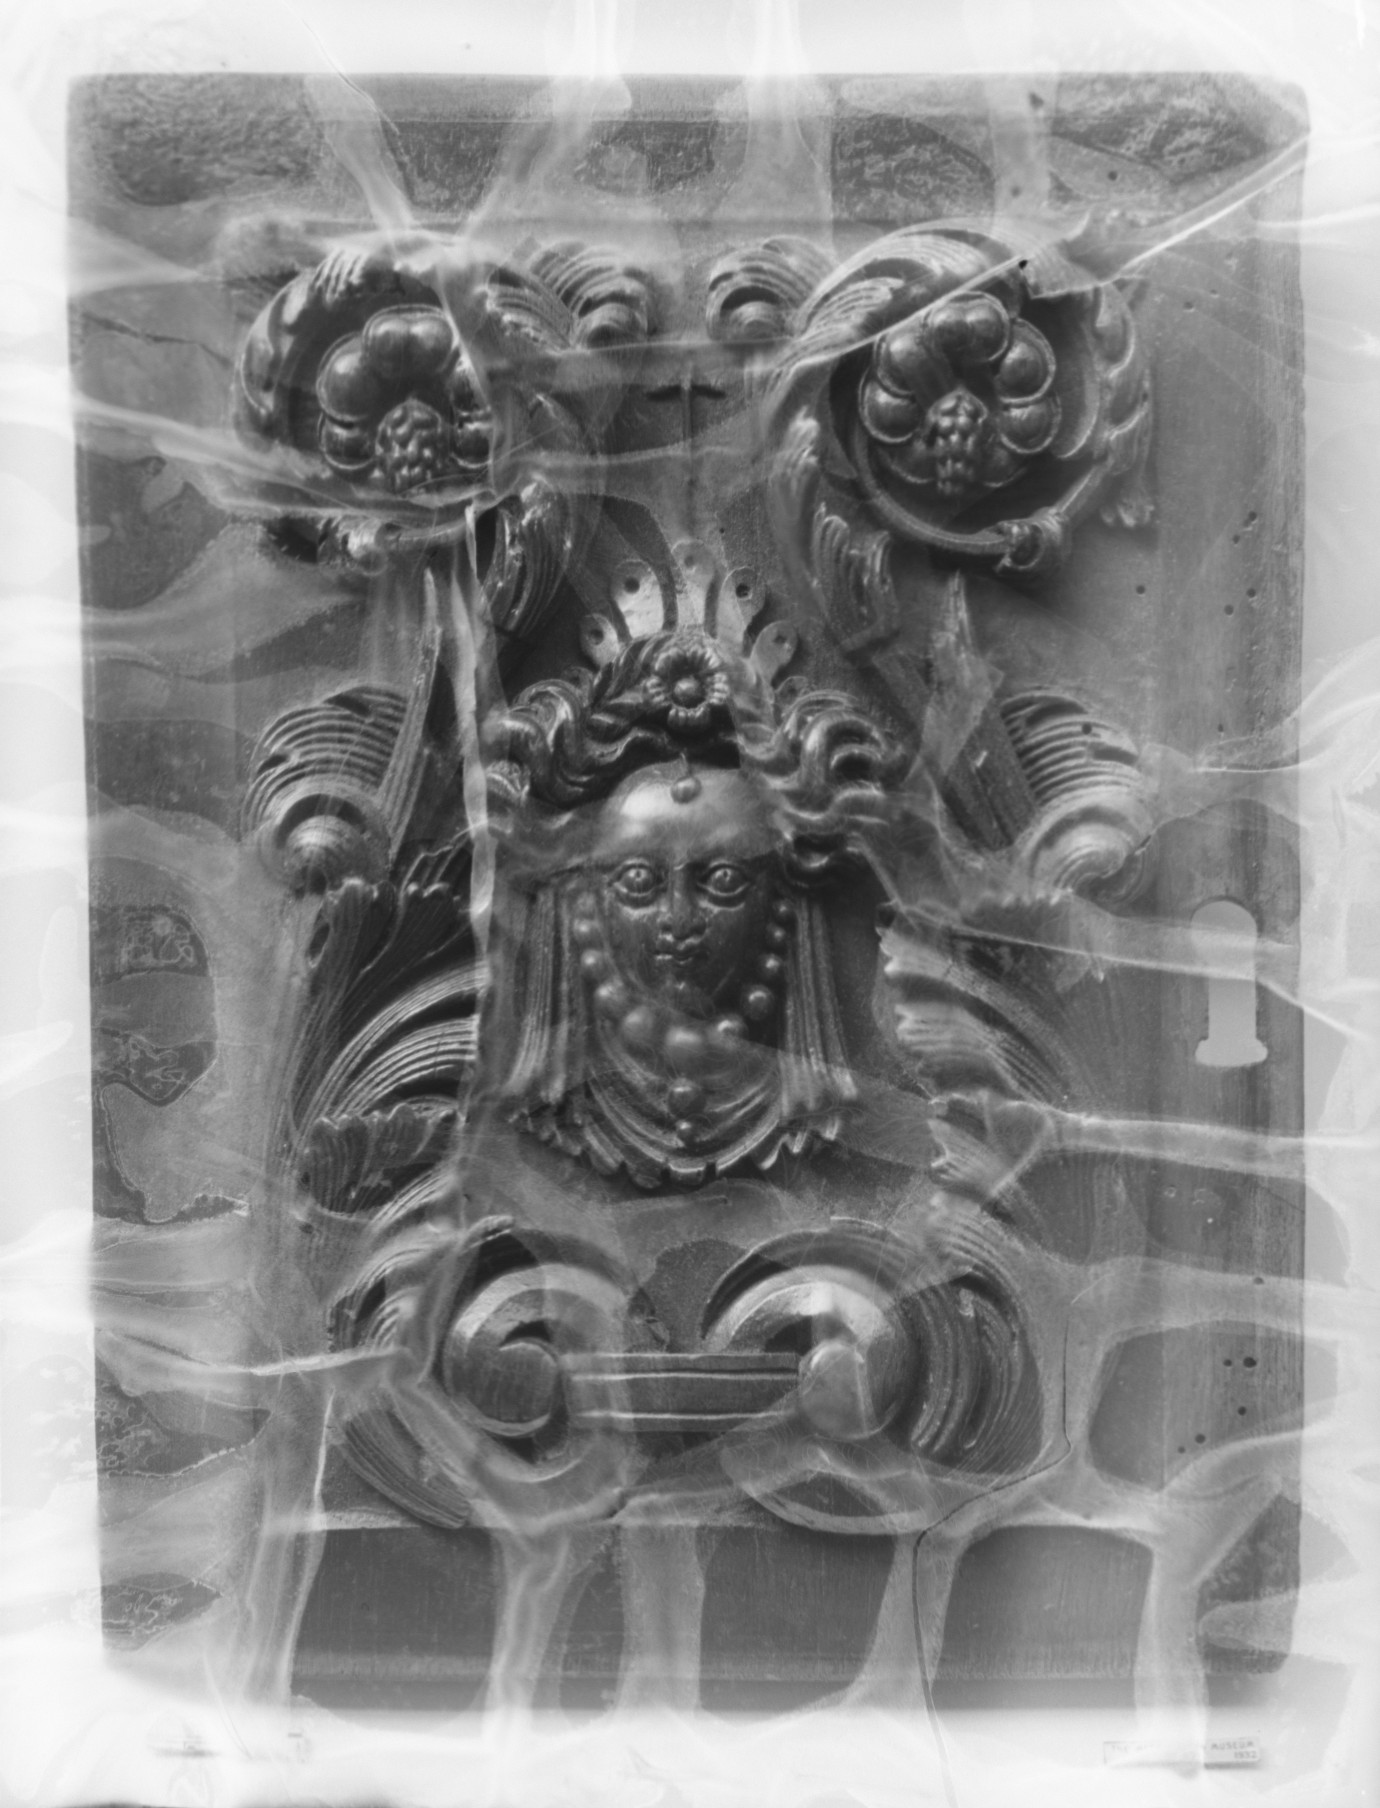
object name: panel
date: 1501-1600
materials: wood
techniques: carving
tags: faces